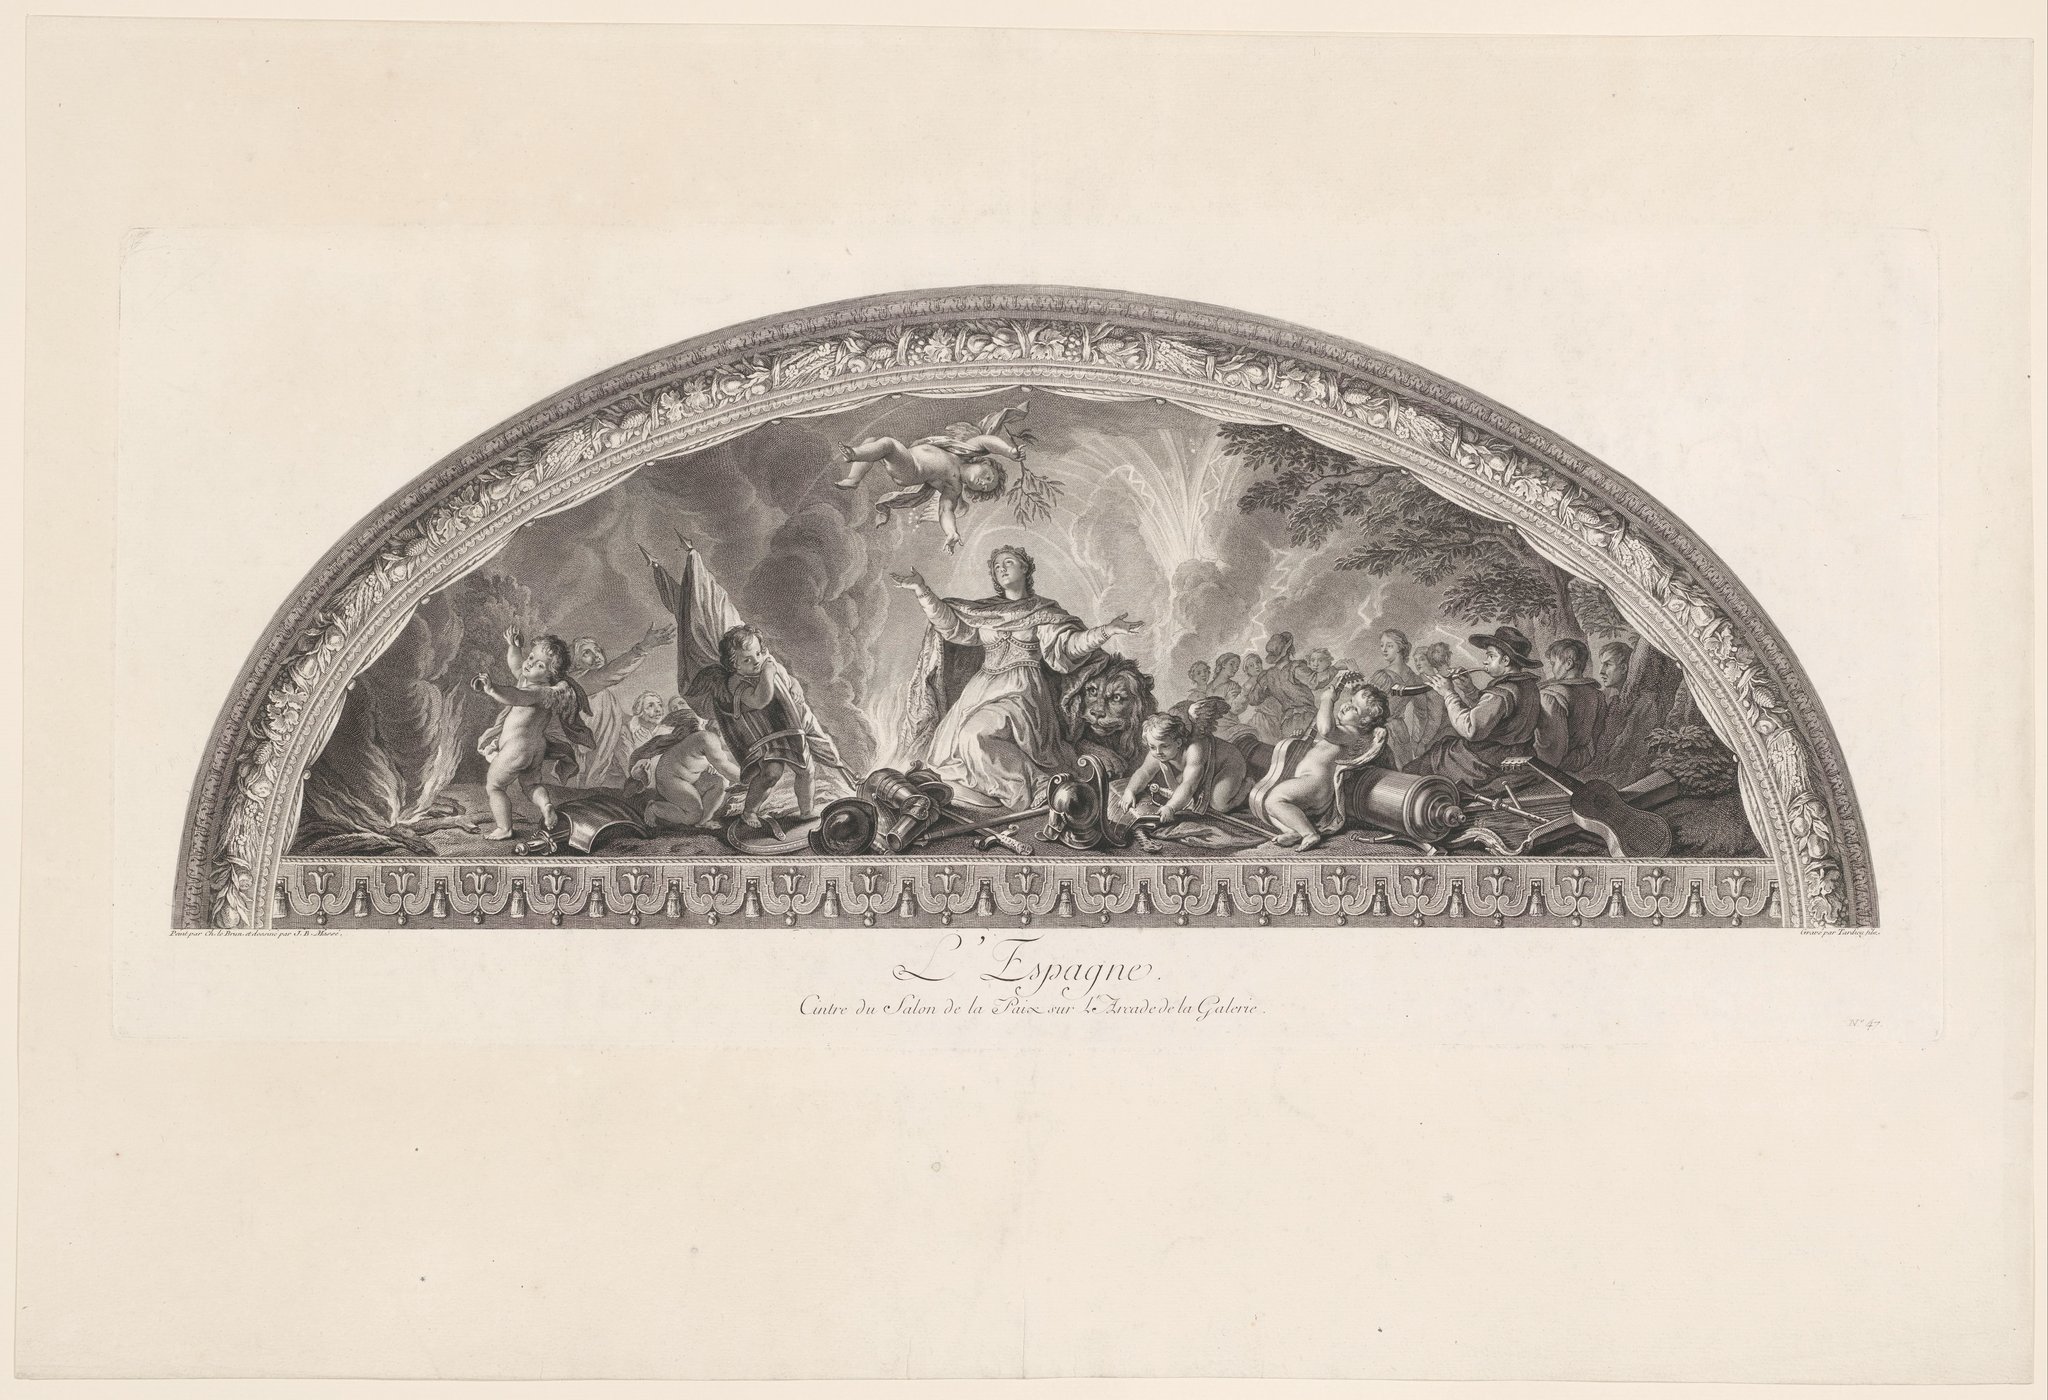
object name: print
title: L'Espagne, cintre du salon de la Paix sur l'arcade de la Galerie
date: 1752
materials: paper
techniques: engraving, etching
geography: france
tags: personifications of countries, nations, states, districts, etc., weapons, private festivities, merry company - aa - in the open air, 'fête champêtre', tapestry, beasts of prey, predatory animals: lion, cupids: 'amores', 'amoretti', 'putti'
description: Prent uit: Massé, Jean Baptiste. La Grande Galerie de Versailles, et les deux salons qui l'accompagnent, peints par Charles le Brun premier peintre de Louis XIV, dessinés par Jean- Baptiste Masse peintre et conseiller de l'Academie royale de peinture & sculpture; et gravés sous ses yeux par les meilleurs maitres du tems. Parijs: Imprimerie Royale, 1752.